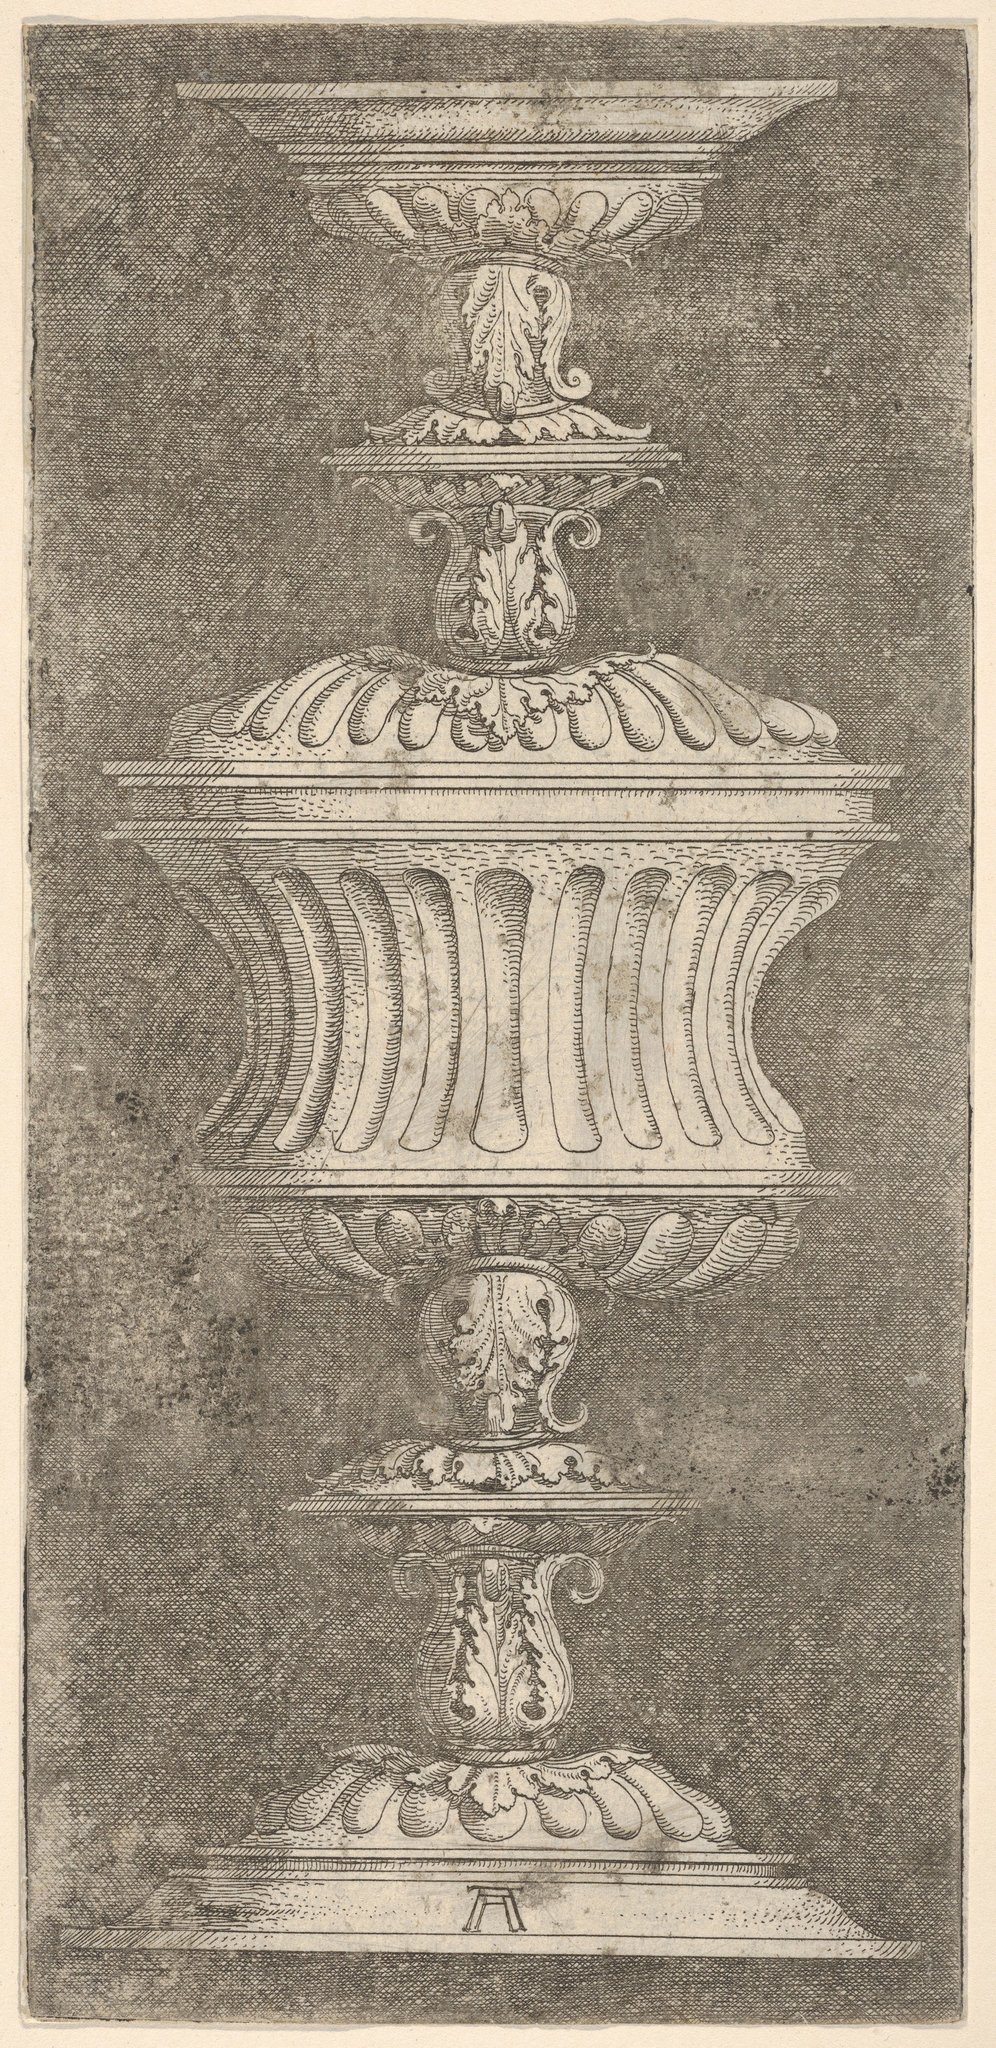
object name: print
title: Double Goblet with Flutes and Acanthus-Leaves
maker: albrecht altdorfer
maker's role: artist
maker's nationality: german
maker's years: 1480-1538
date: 1500-1538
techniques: etching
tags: drinking glasses